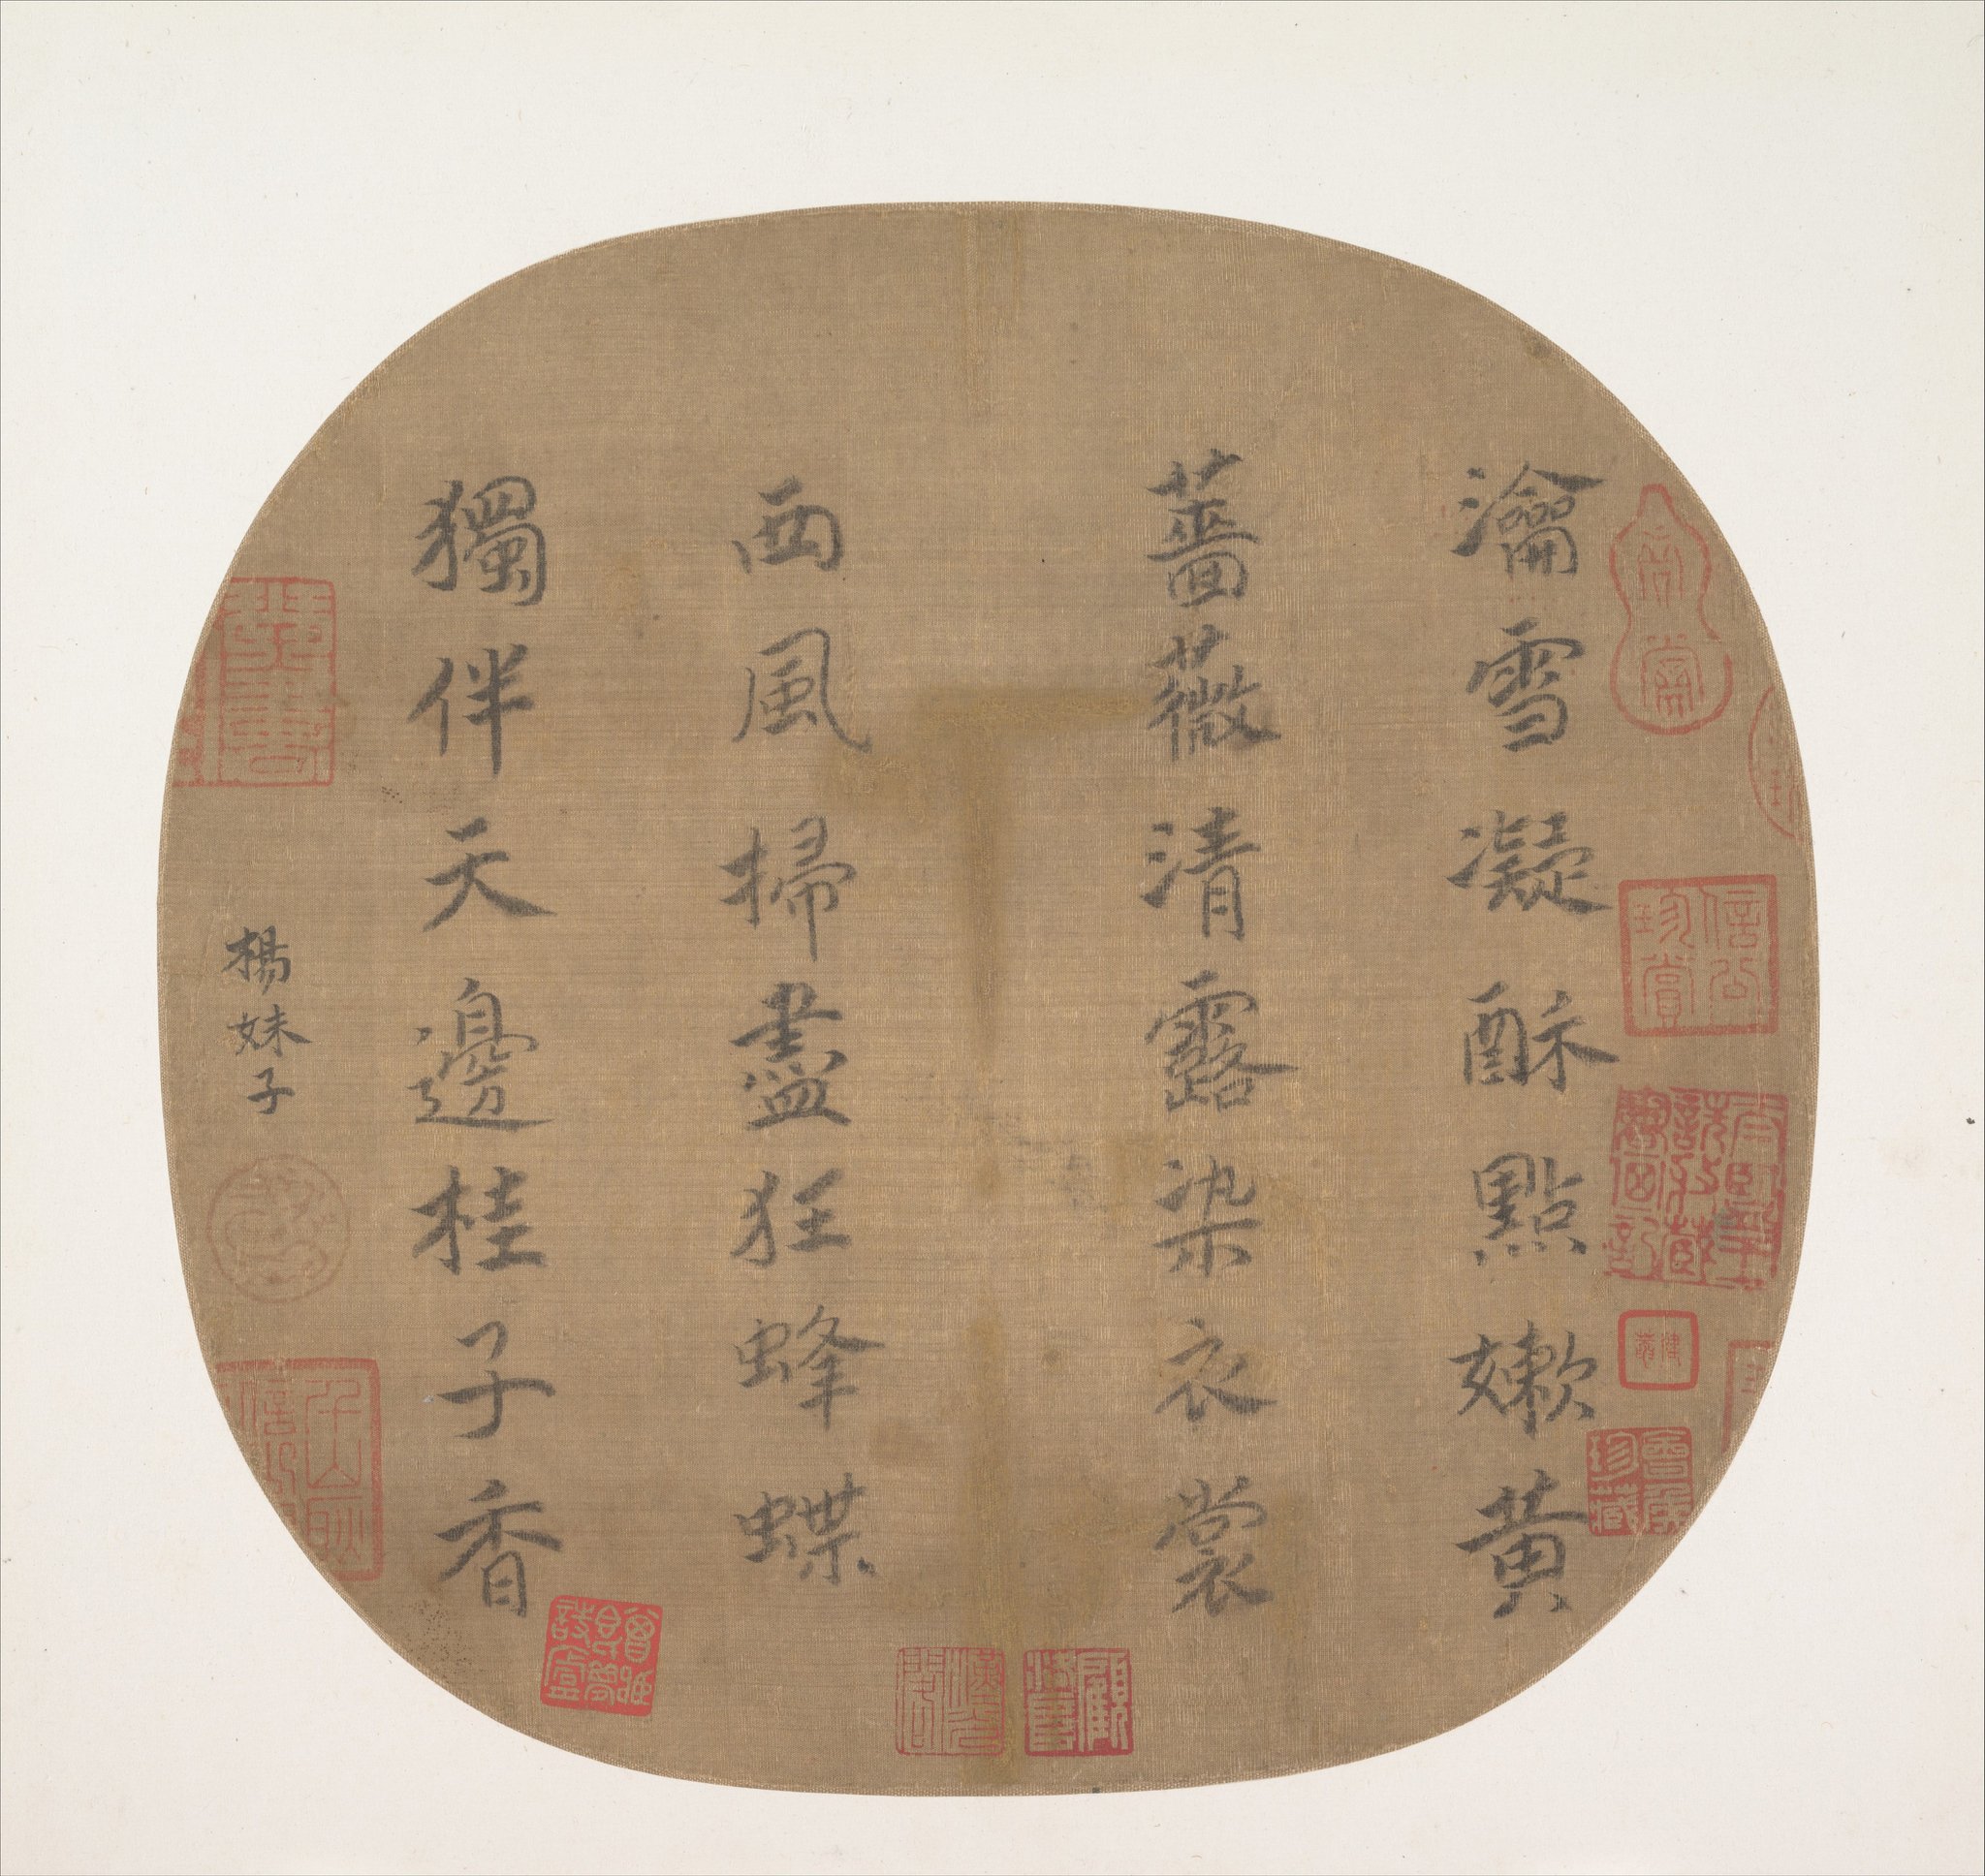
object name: fan mounted a an album leaf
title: Quatrain on yellow roses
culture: chinese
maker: empress yang meizi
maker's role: artist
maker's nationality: chinese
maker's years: 1162-1232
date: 1201-1233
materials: ink, silk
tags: poetry,calligraphy